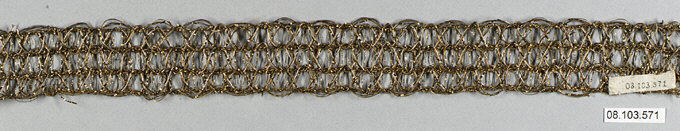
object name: galloon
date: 1701-1800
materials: metal thread